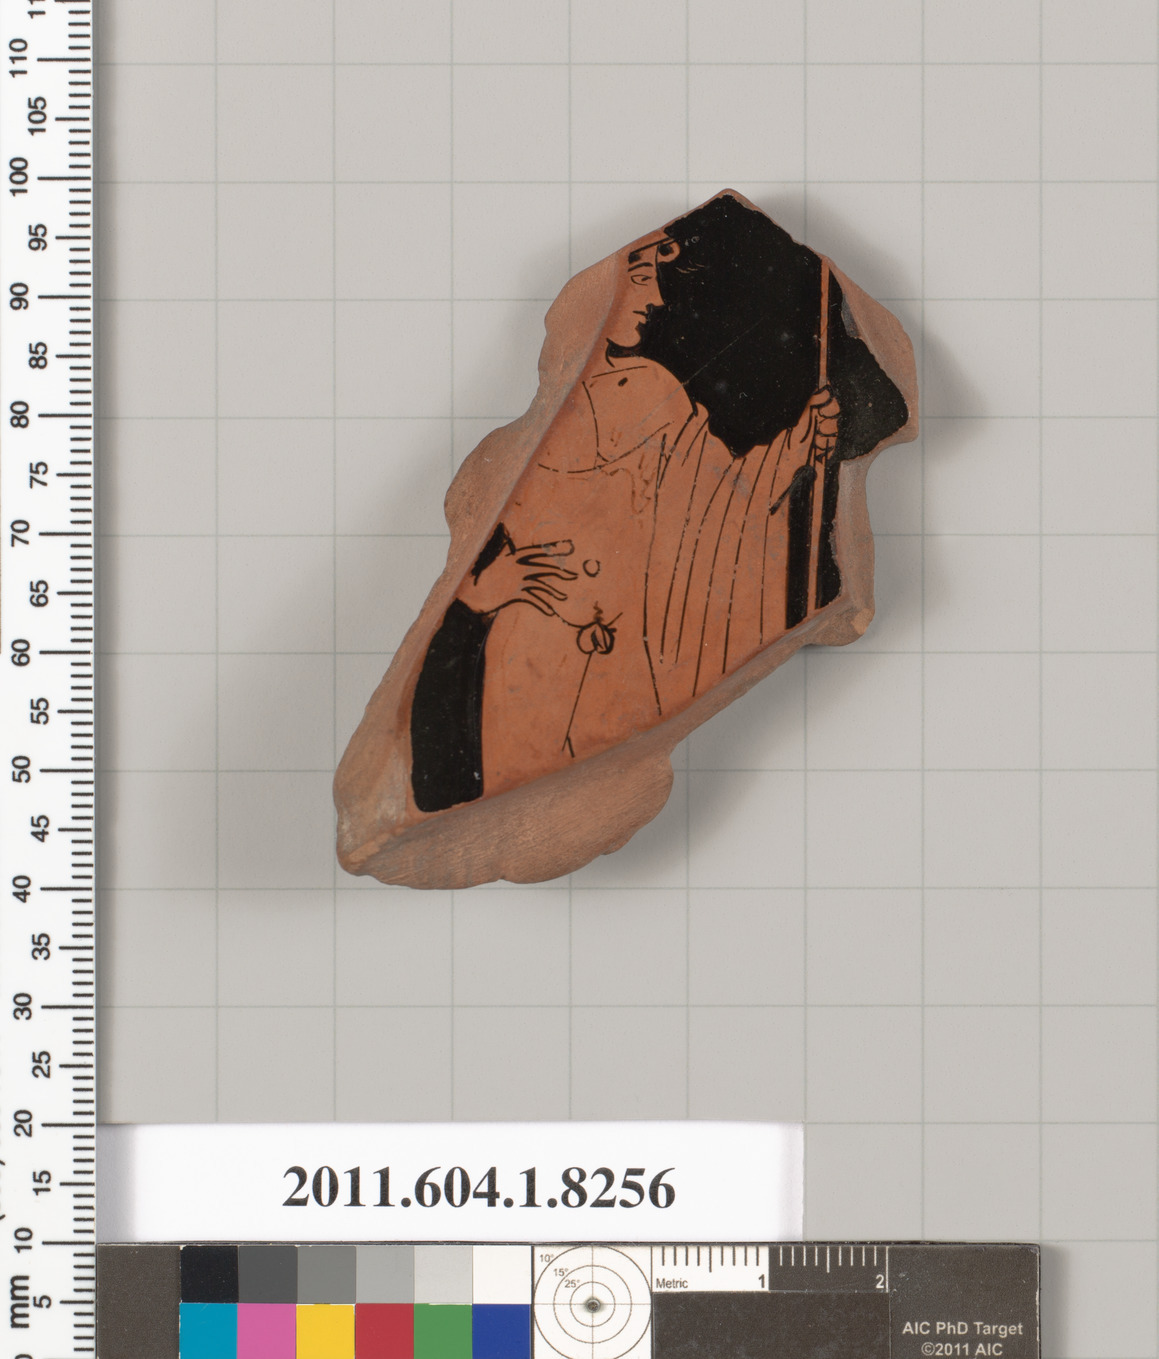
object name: kylix fragment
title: Terracotta fragment of a kylix (drinking cup)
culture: greek, attic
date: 460-450 BCE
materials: terracotta